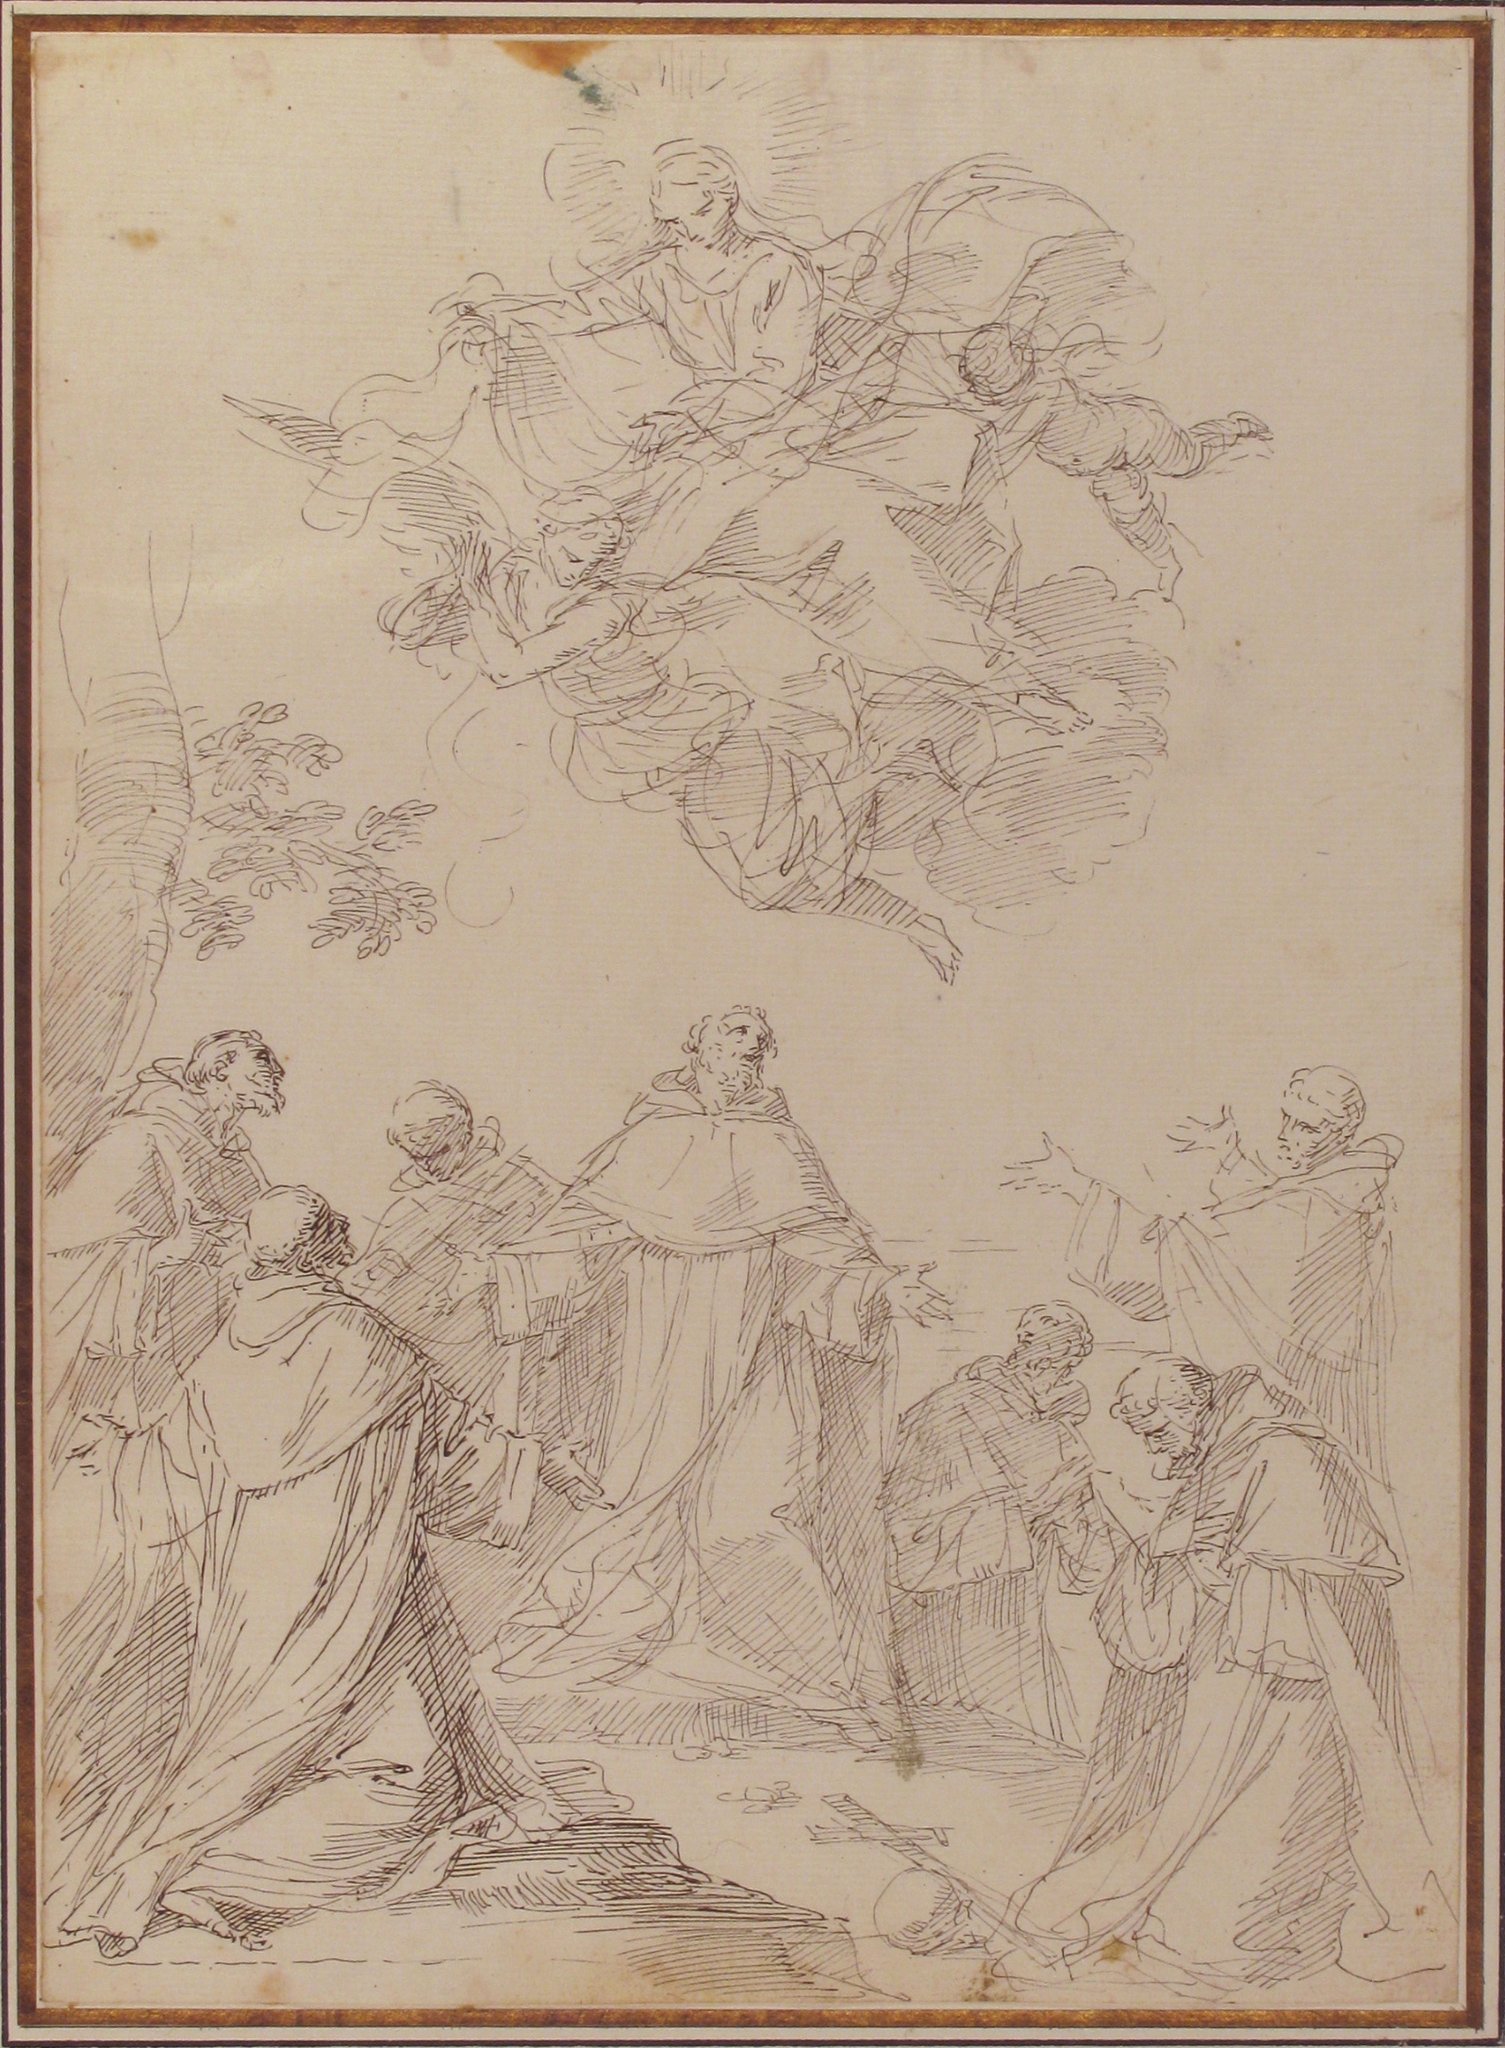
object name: drawing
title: The Virgin Bringing the Habit to the Seven Founding Fathers of the Servite Order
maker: donato creti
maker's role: artist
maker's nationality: italian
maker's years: 1671-1749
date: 1671-1749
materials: ink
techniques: pen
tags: fathers,angels,virgin mary